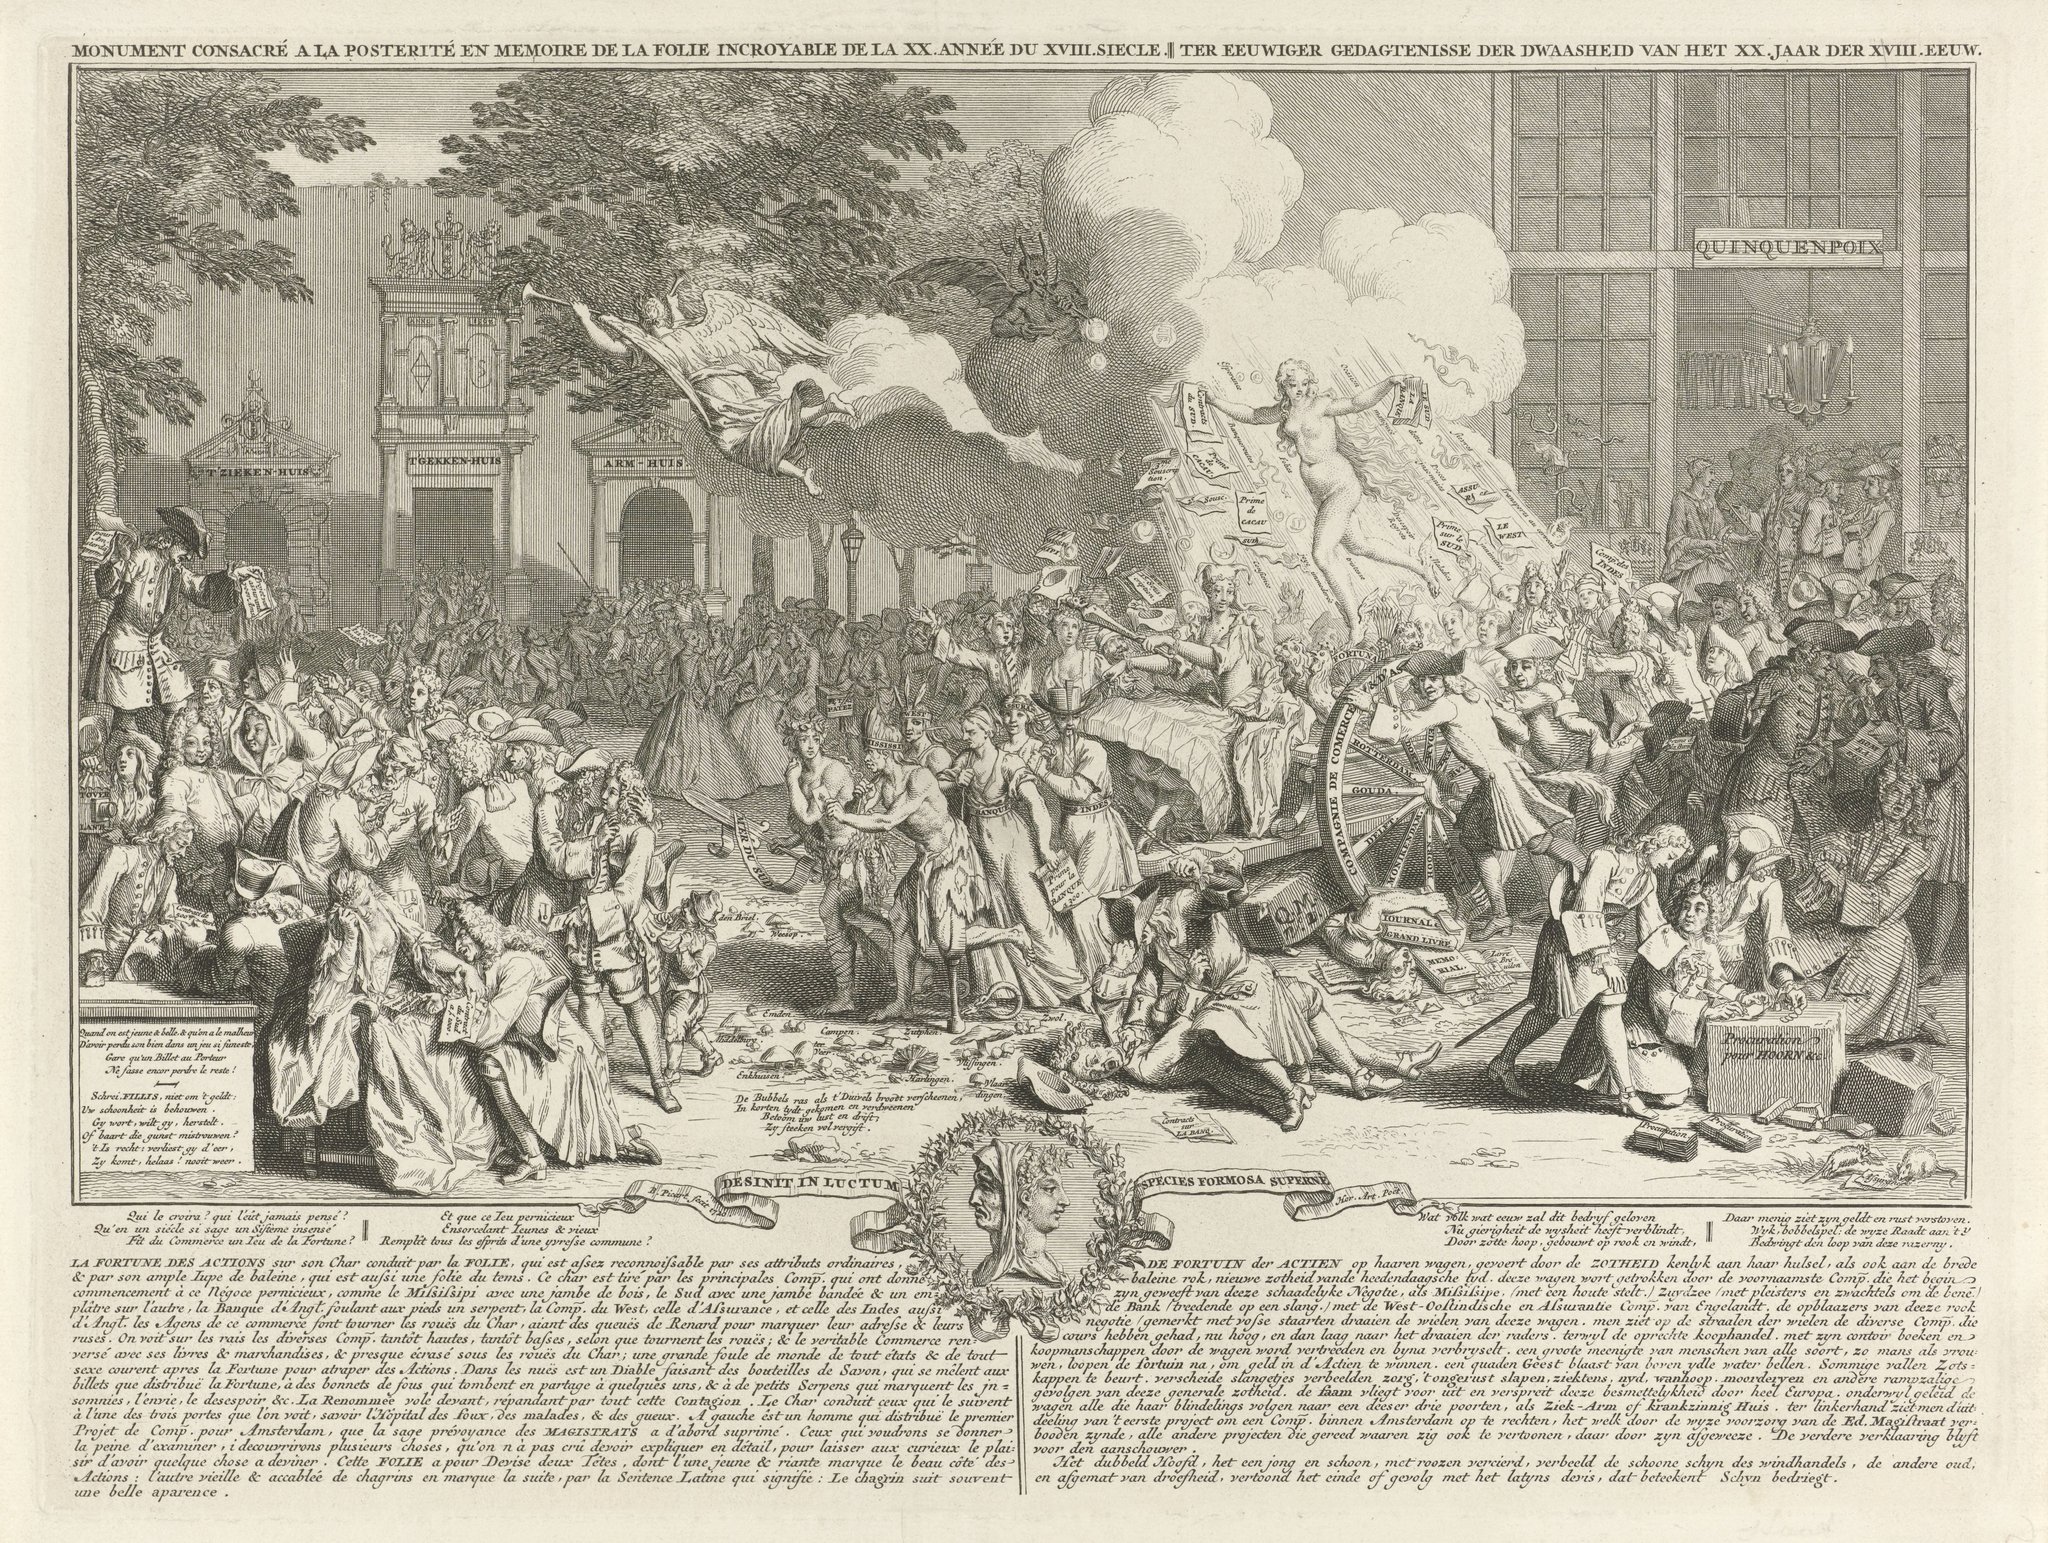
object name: cartoon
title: Monument consacré a la posterité en memoire de la folie incroyable de la XX. année du XVIII. siecle / Ter eeuwiger gedagtenisse der dwaasheid van het XX. jaar der XVIII. eeuw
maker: bernard picart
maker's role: draughtsman, print maker, publisher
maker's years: 1673-1733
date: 1720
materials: paper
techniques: engraving, etching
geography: amsterdam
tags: financial panic, indigenous peoples of north america, indigenous peoples of south america, luck, fortune, lot; 'fato', 'fortuna', 'fortuna aurea', 'fortuna buona', 'fortuna pacifica overo clemente', 'sorte' (ripa), lunatic asylum, mental home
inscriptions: collector's mark: Lugt 2228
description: Monument ter herinnering aan de dwaasheid van het jaar 1720. Op een grote wagen gemend door een nar strooit de Fortuin van de Actien aandelen in het rond. De kar wordt getrokken door personificaties van de compagnieën van de Zuidzee en Mississippi (een invalide indiaan) en anderen. De wagen wordt door de Faam geleid in de richting van een armenhuis en gekkenhuis. Om de kar staan handelaren en gedupeerden. Rechts op de achtergrond het Koffiehuis Quincampoix. Onderaan het embleem met de motto Schijn Bedriegt in het Latijn. In het onderschrift de verklaring van de voorstelling in het Frans en Nederlands. Prent 18 in de serie Het Groote Tafereel der Dwaasheid met spotprenten op de Windhandel of Actiehandel van 1720.